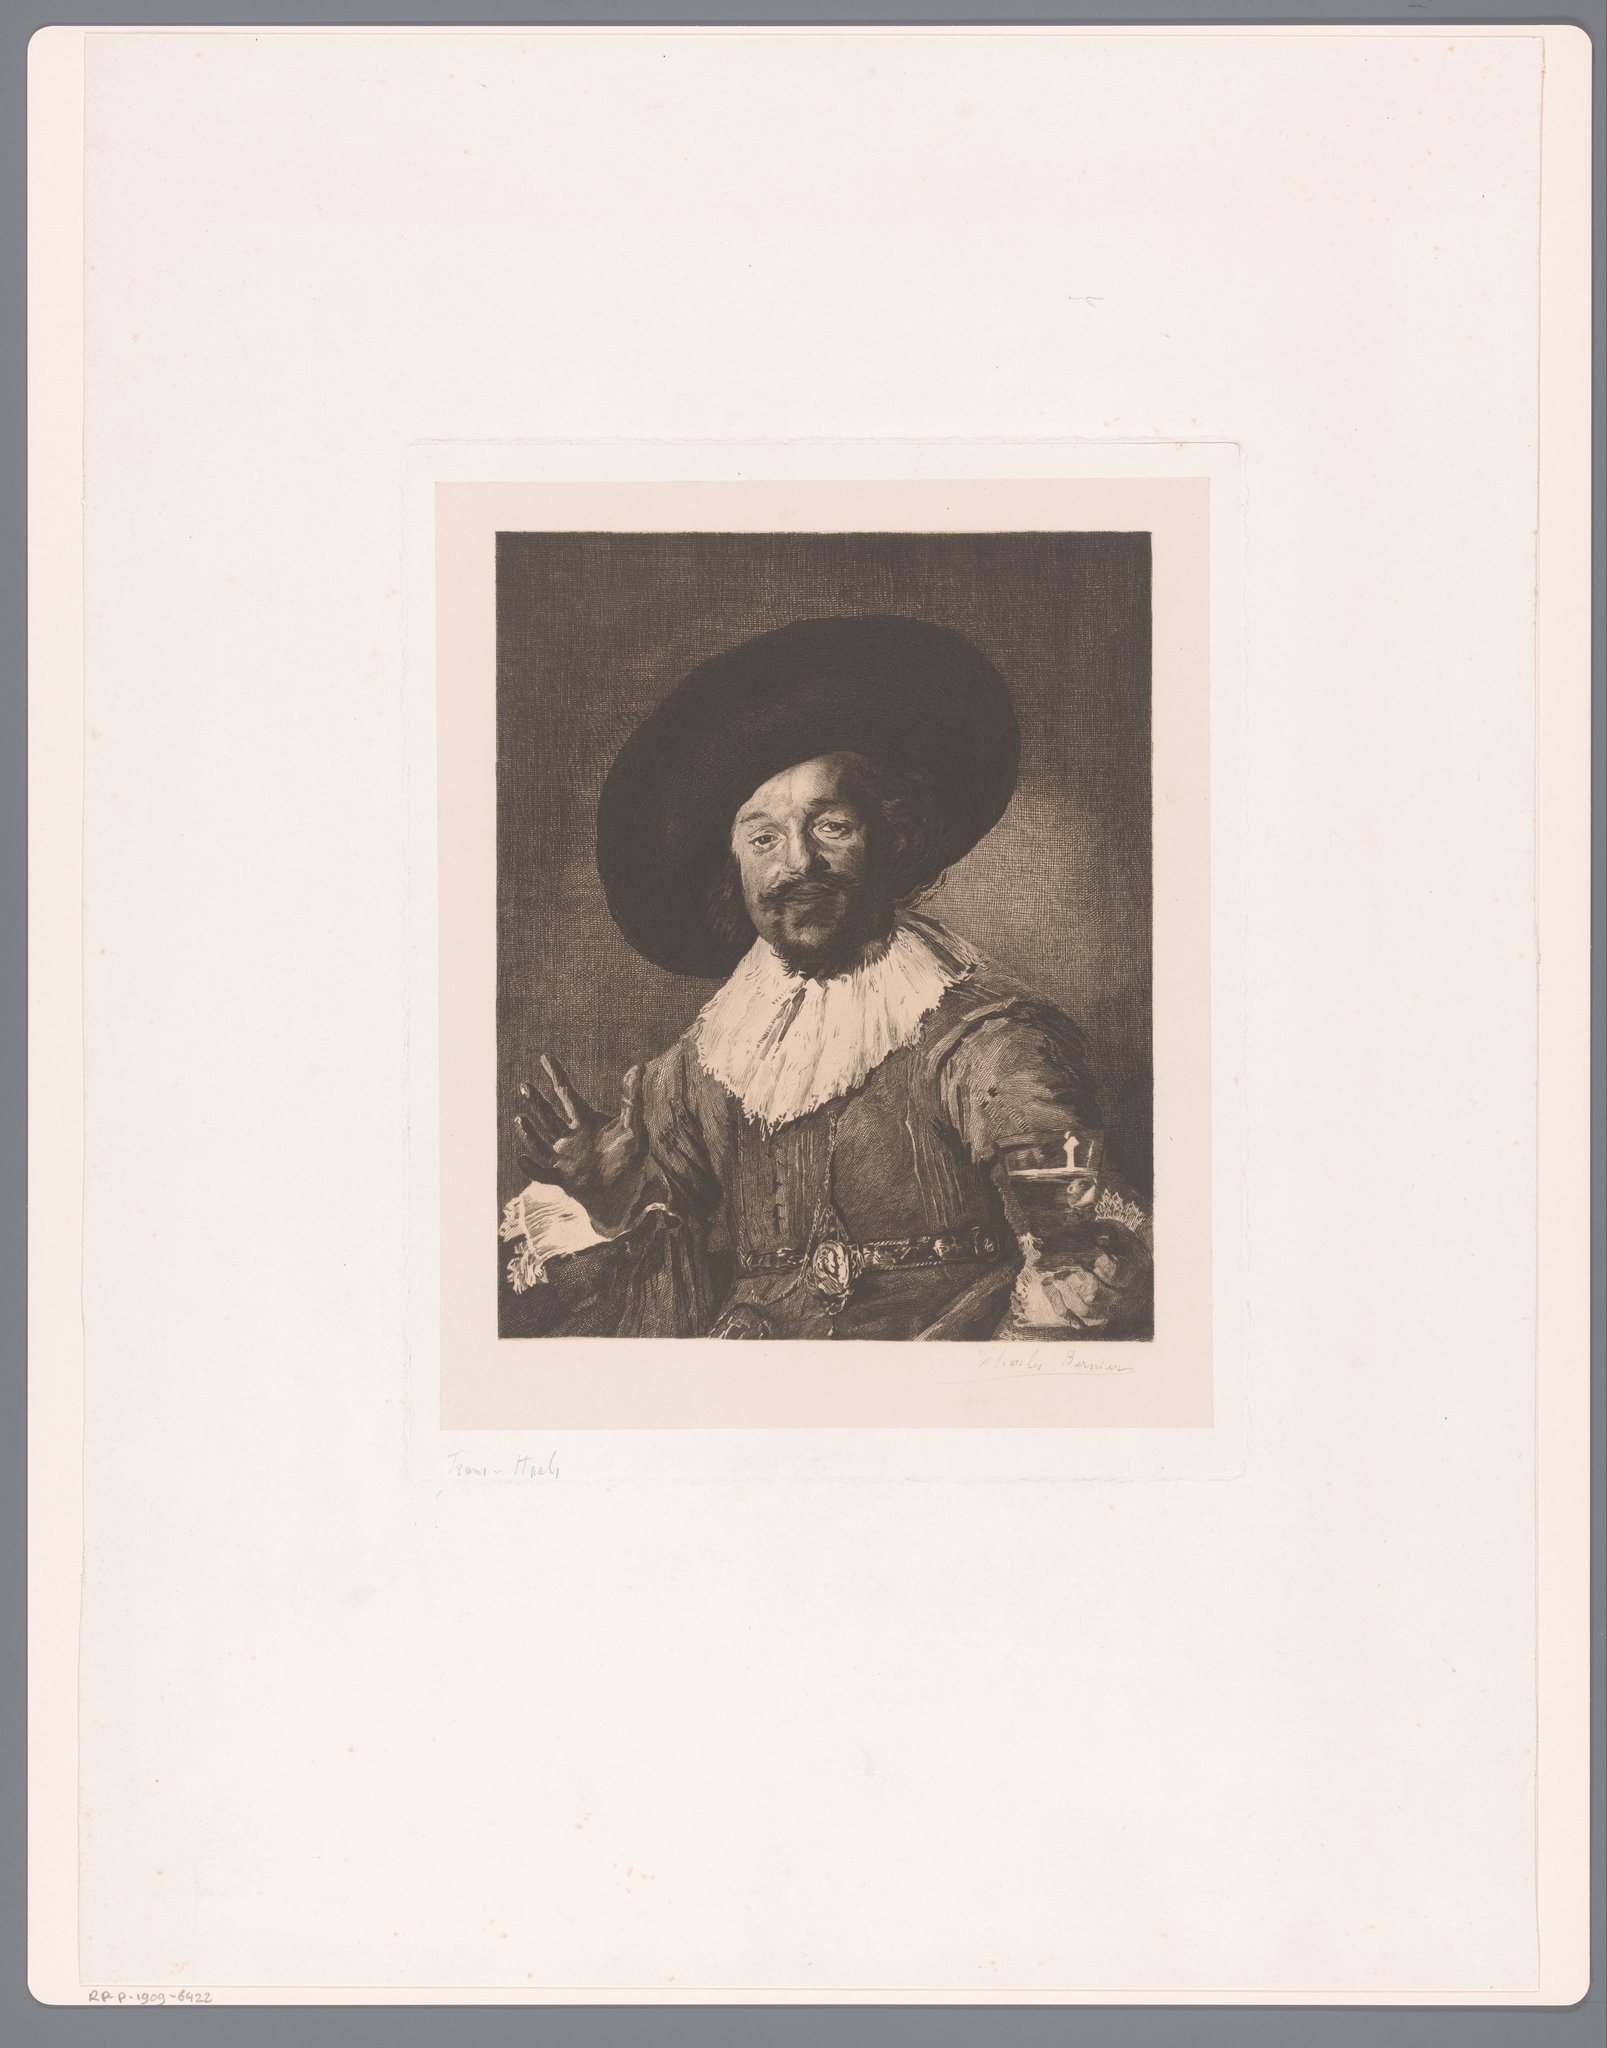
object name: print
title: De vrolijke drinker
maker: charles théodore bernier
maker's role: print maker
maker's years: 1871-1950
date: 1888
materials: paper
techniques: etching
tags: head-gear and clothing for the upper part of the body, adult man, drinking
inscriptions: collector's mark: Lugt 2228